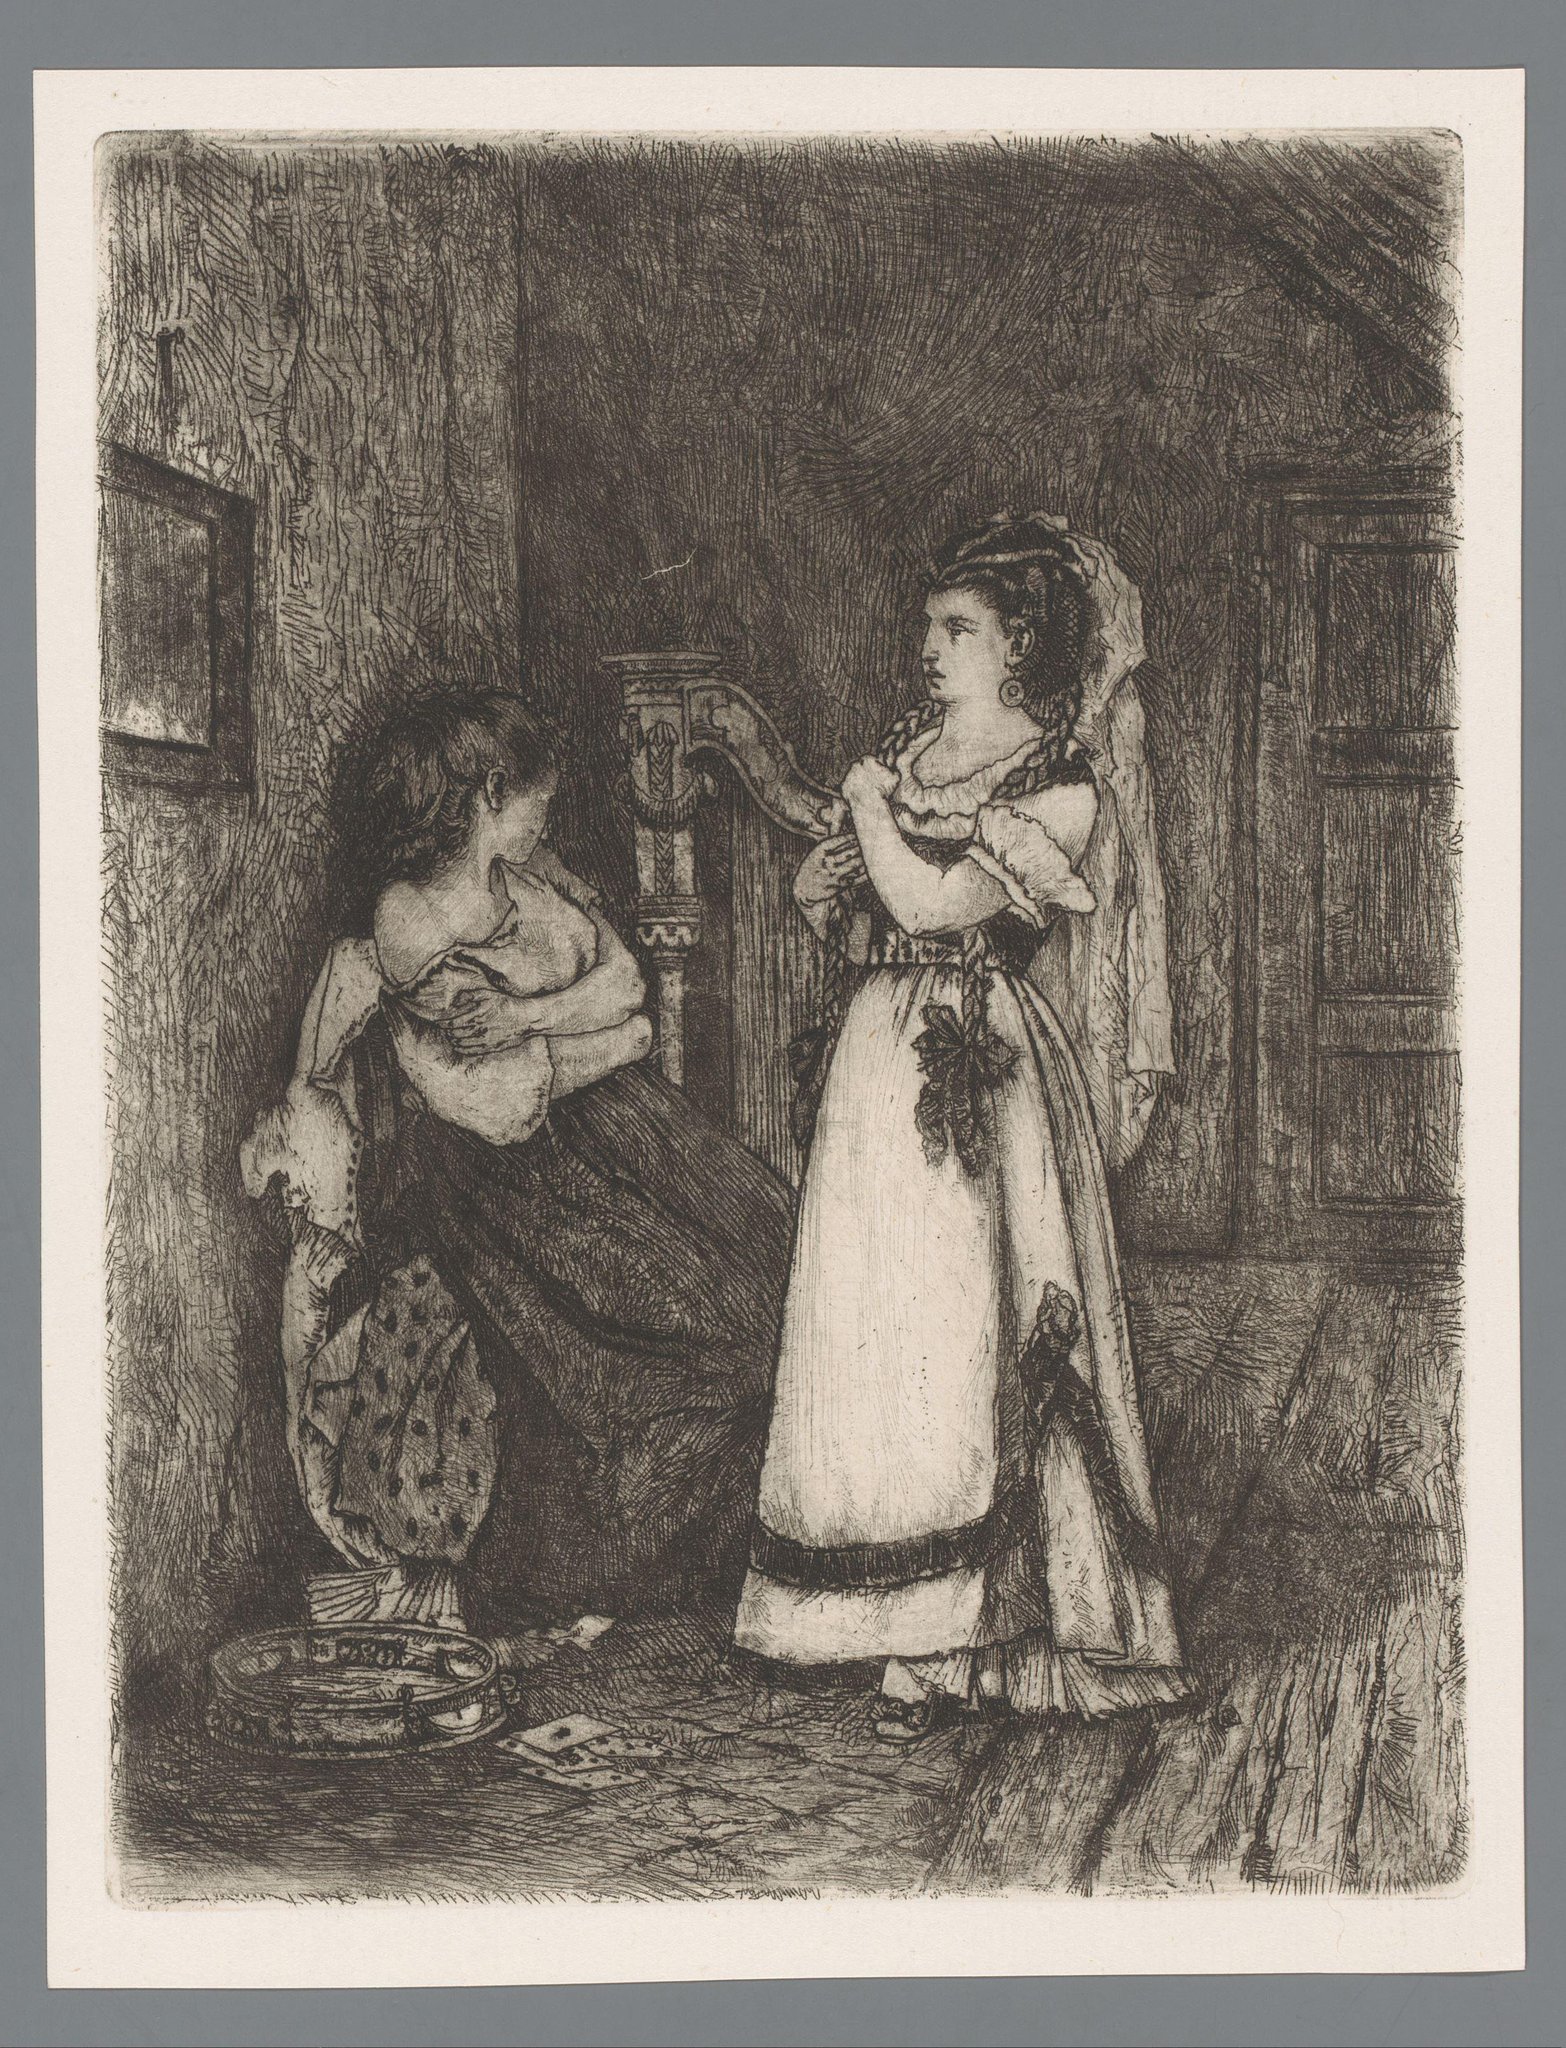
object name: print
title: Twee Romavrouwen in een vertrek met een harp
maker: willem linnig (ii)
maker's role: print maker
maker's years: 1842-1890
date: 1871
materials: paper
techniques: etching, intaglio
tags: tambourine, wandering communities: romani or roma, harp, playing-cards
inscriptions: collector's mark: Lugt 2228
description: Latere staat van deze prent gebruikt in: Journal des Beaux-arts (1871).